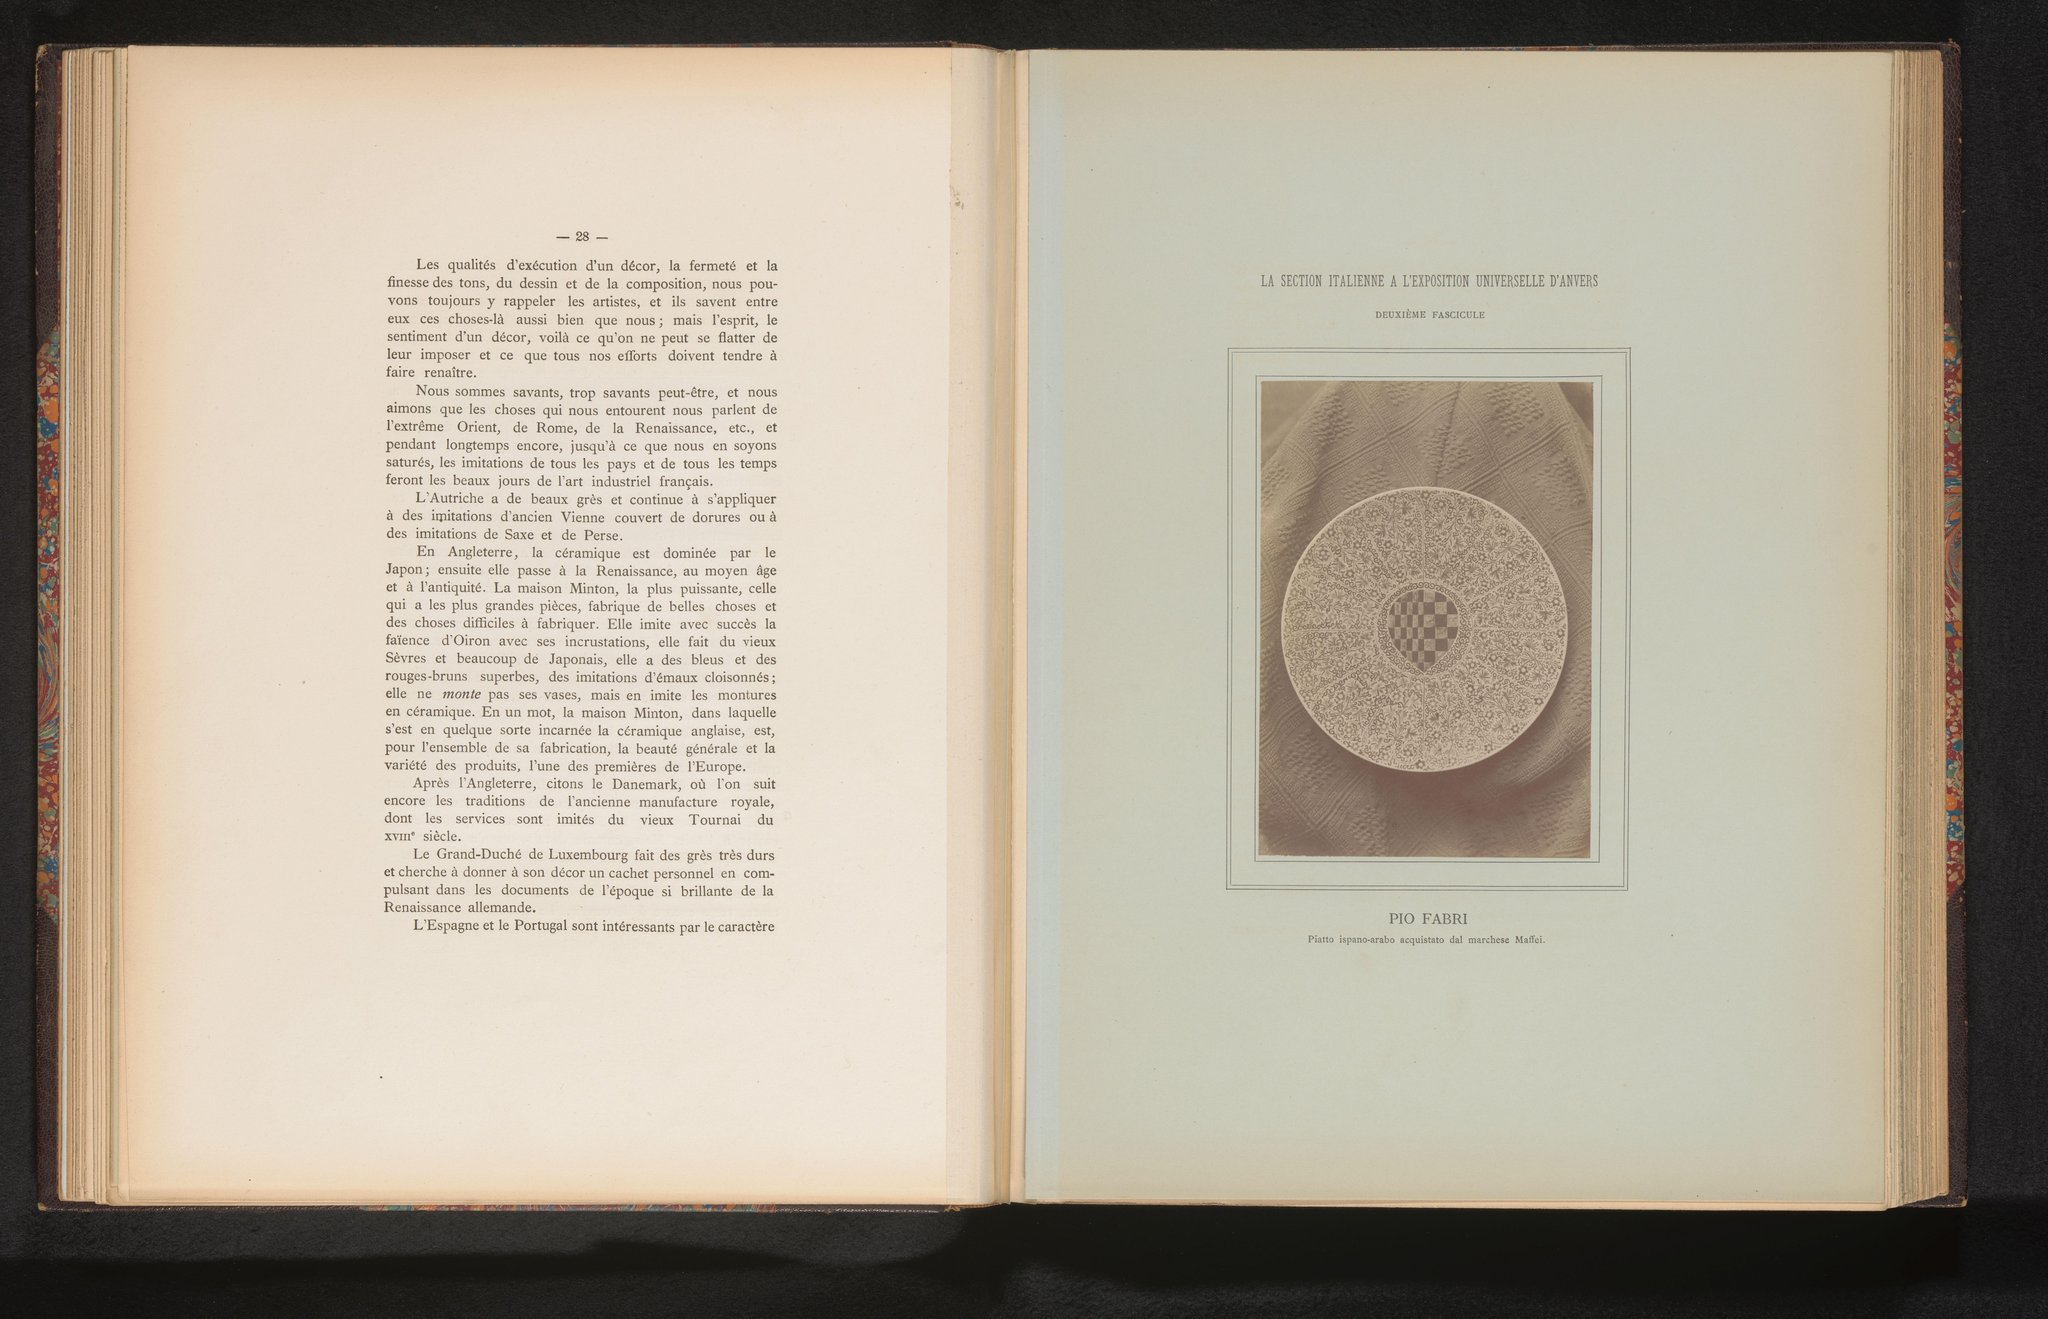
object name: photograph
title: Pio Fabri, piatto ispano-arabo acquistato dal marchese Maffei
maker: Anonymous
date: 1880-1885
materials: photographic support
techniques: albumen print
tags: table-ware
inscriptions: inscription: ‘La section Italienne a l'exposition universelle d'Anvers/ premies fascicule’